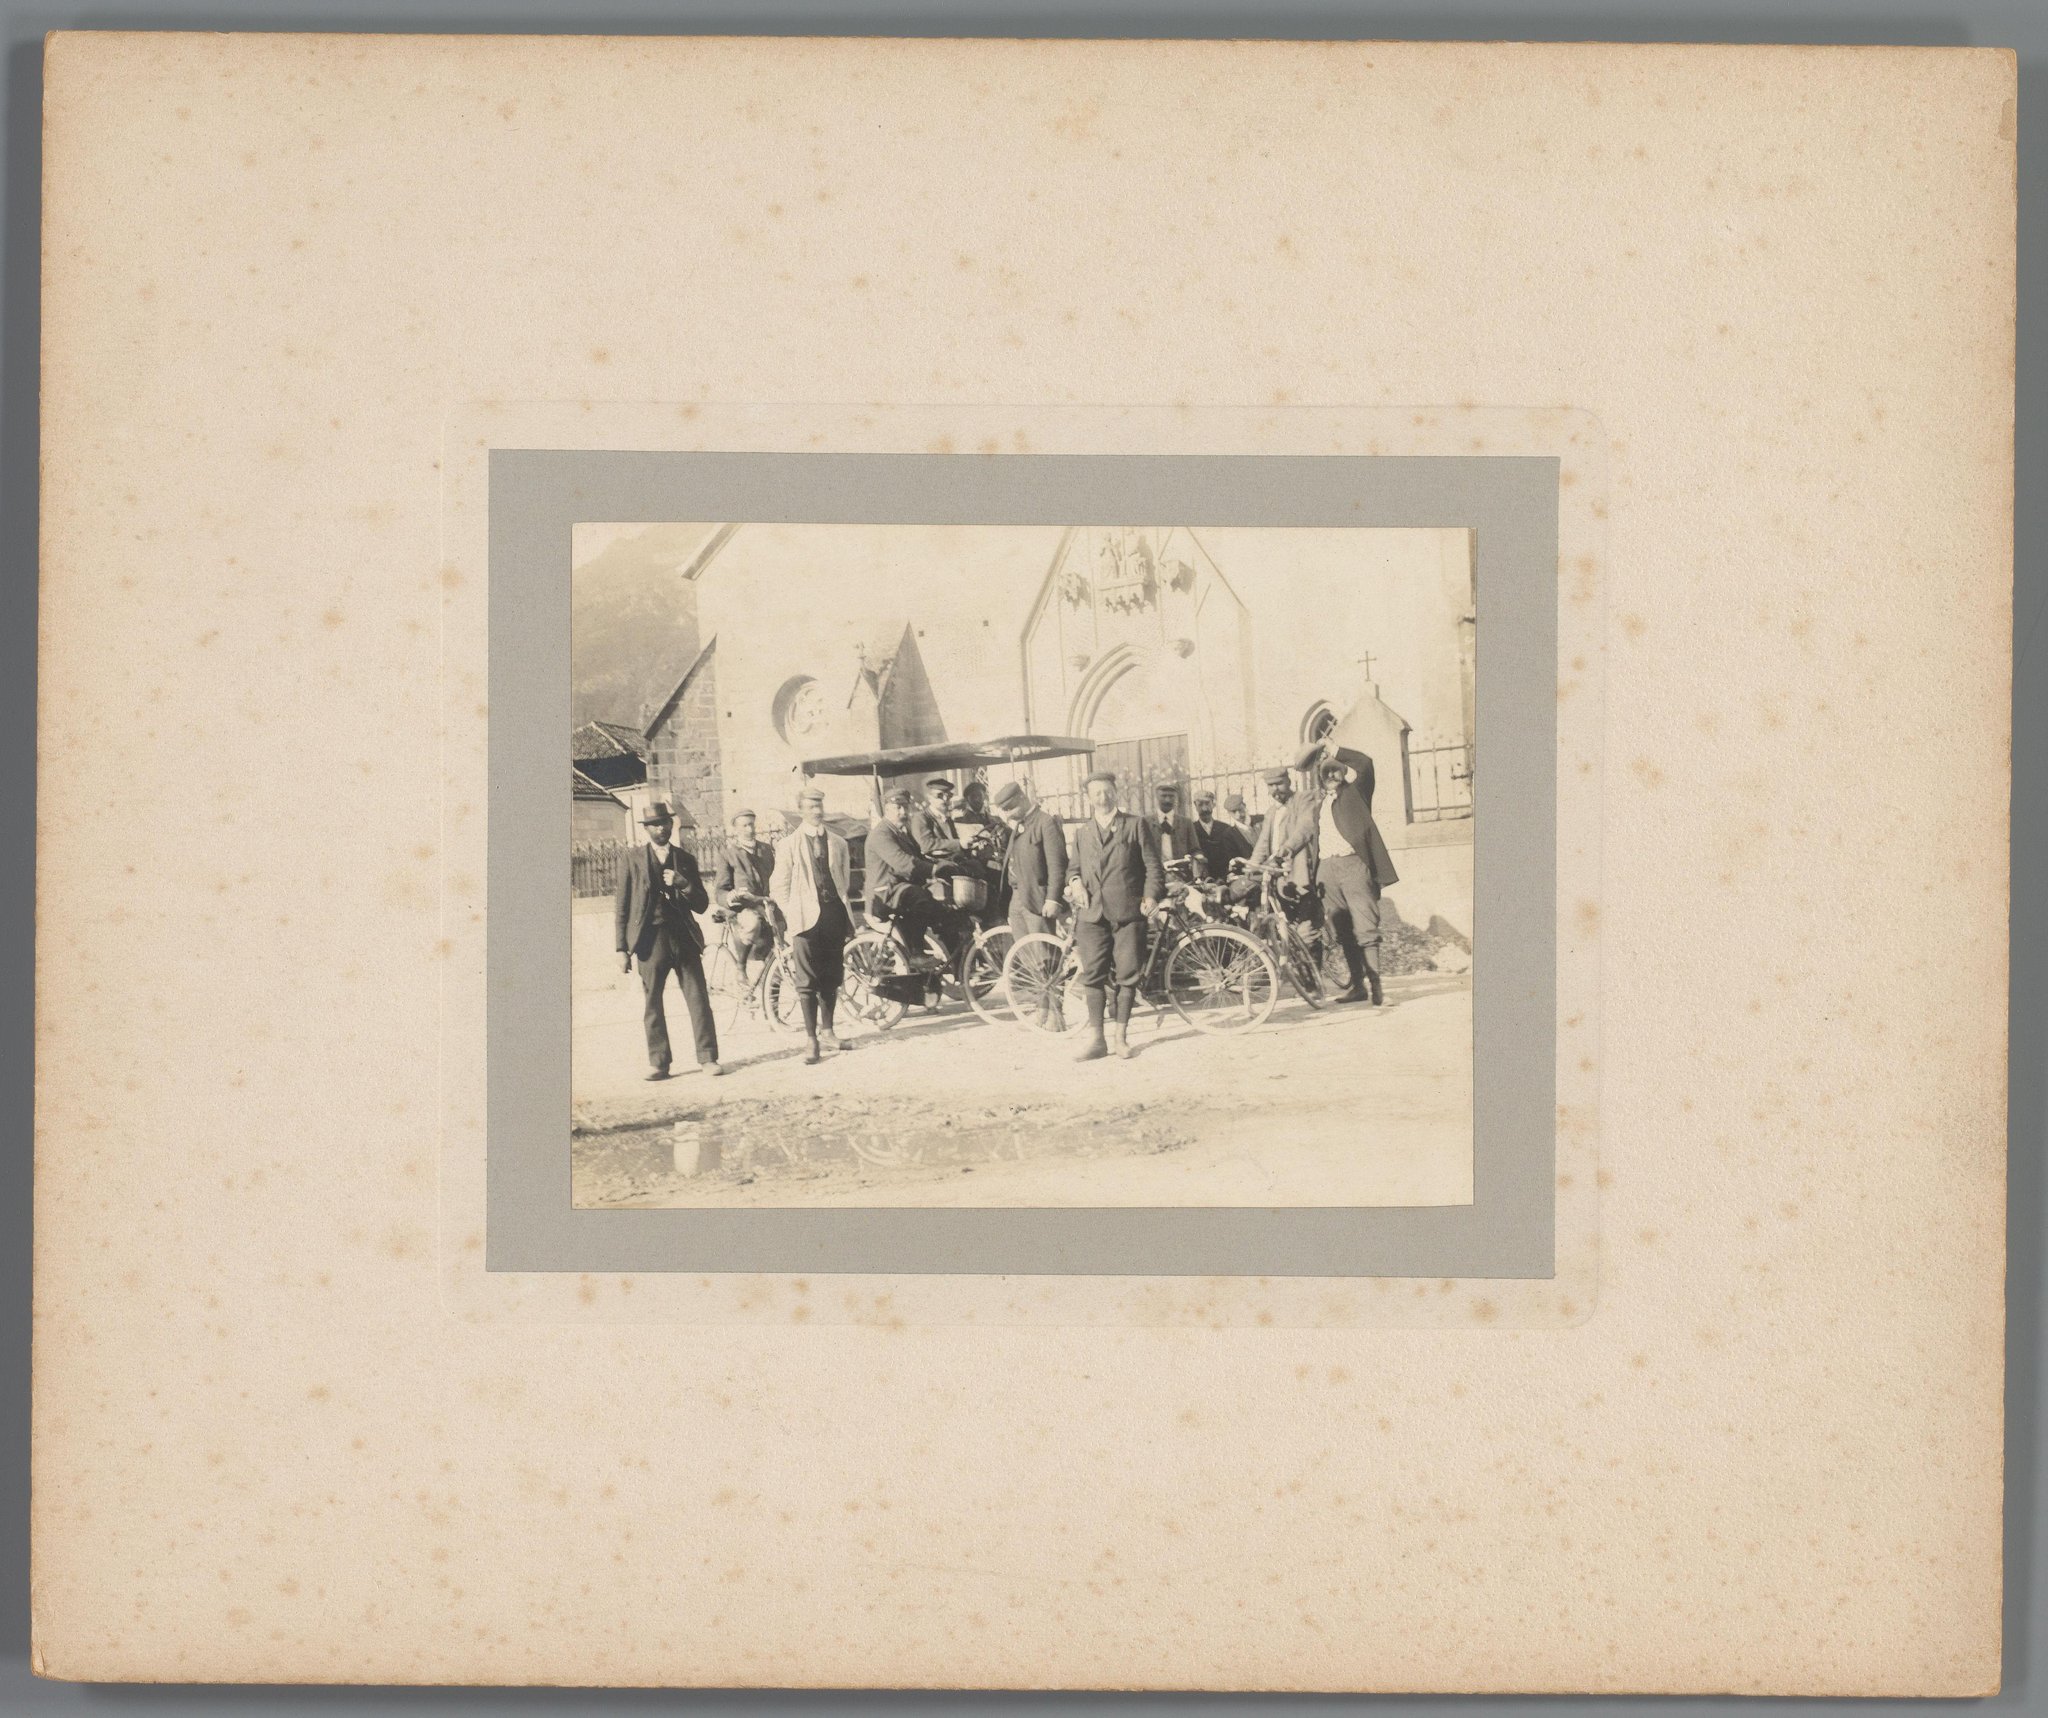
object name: photograph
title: Groepsportret van onbekende fietsers en automobilisten nabij Bolzano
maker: françois buys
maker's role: advocaat, amateurfotograaf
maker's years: 1871-1934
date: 1905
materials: paper, cardboard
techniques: gelatin silver print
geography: bolzano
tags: bicycle, automobile, anonymous historical persons portrayed in a group, in a group-portrait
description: Deze foto maakt deel uit van een groep van 38 foto's.